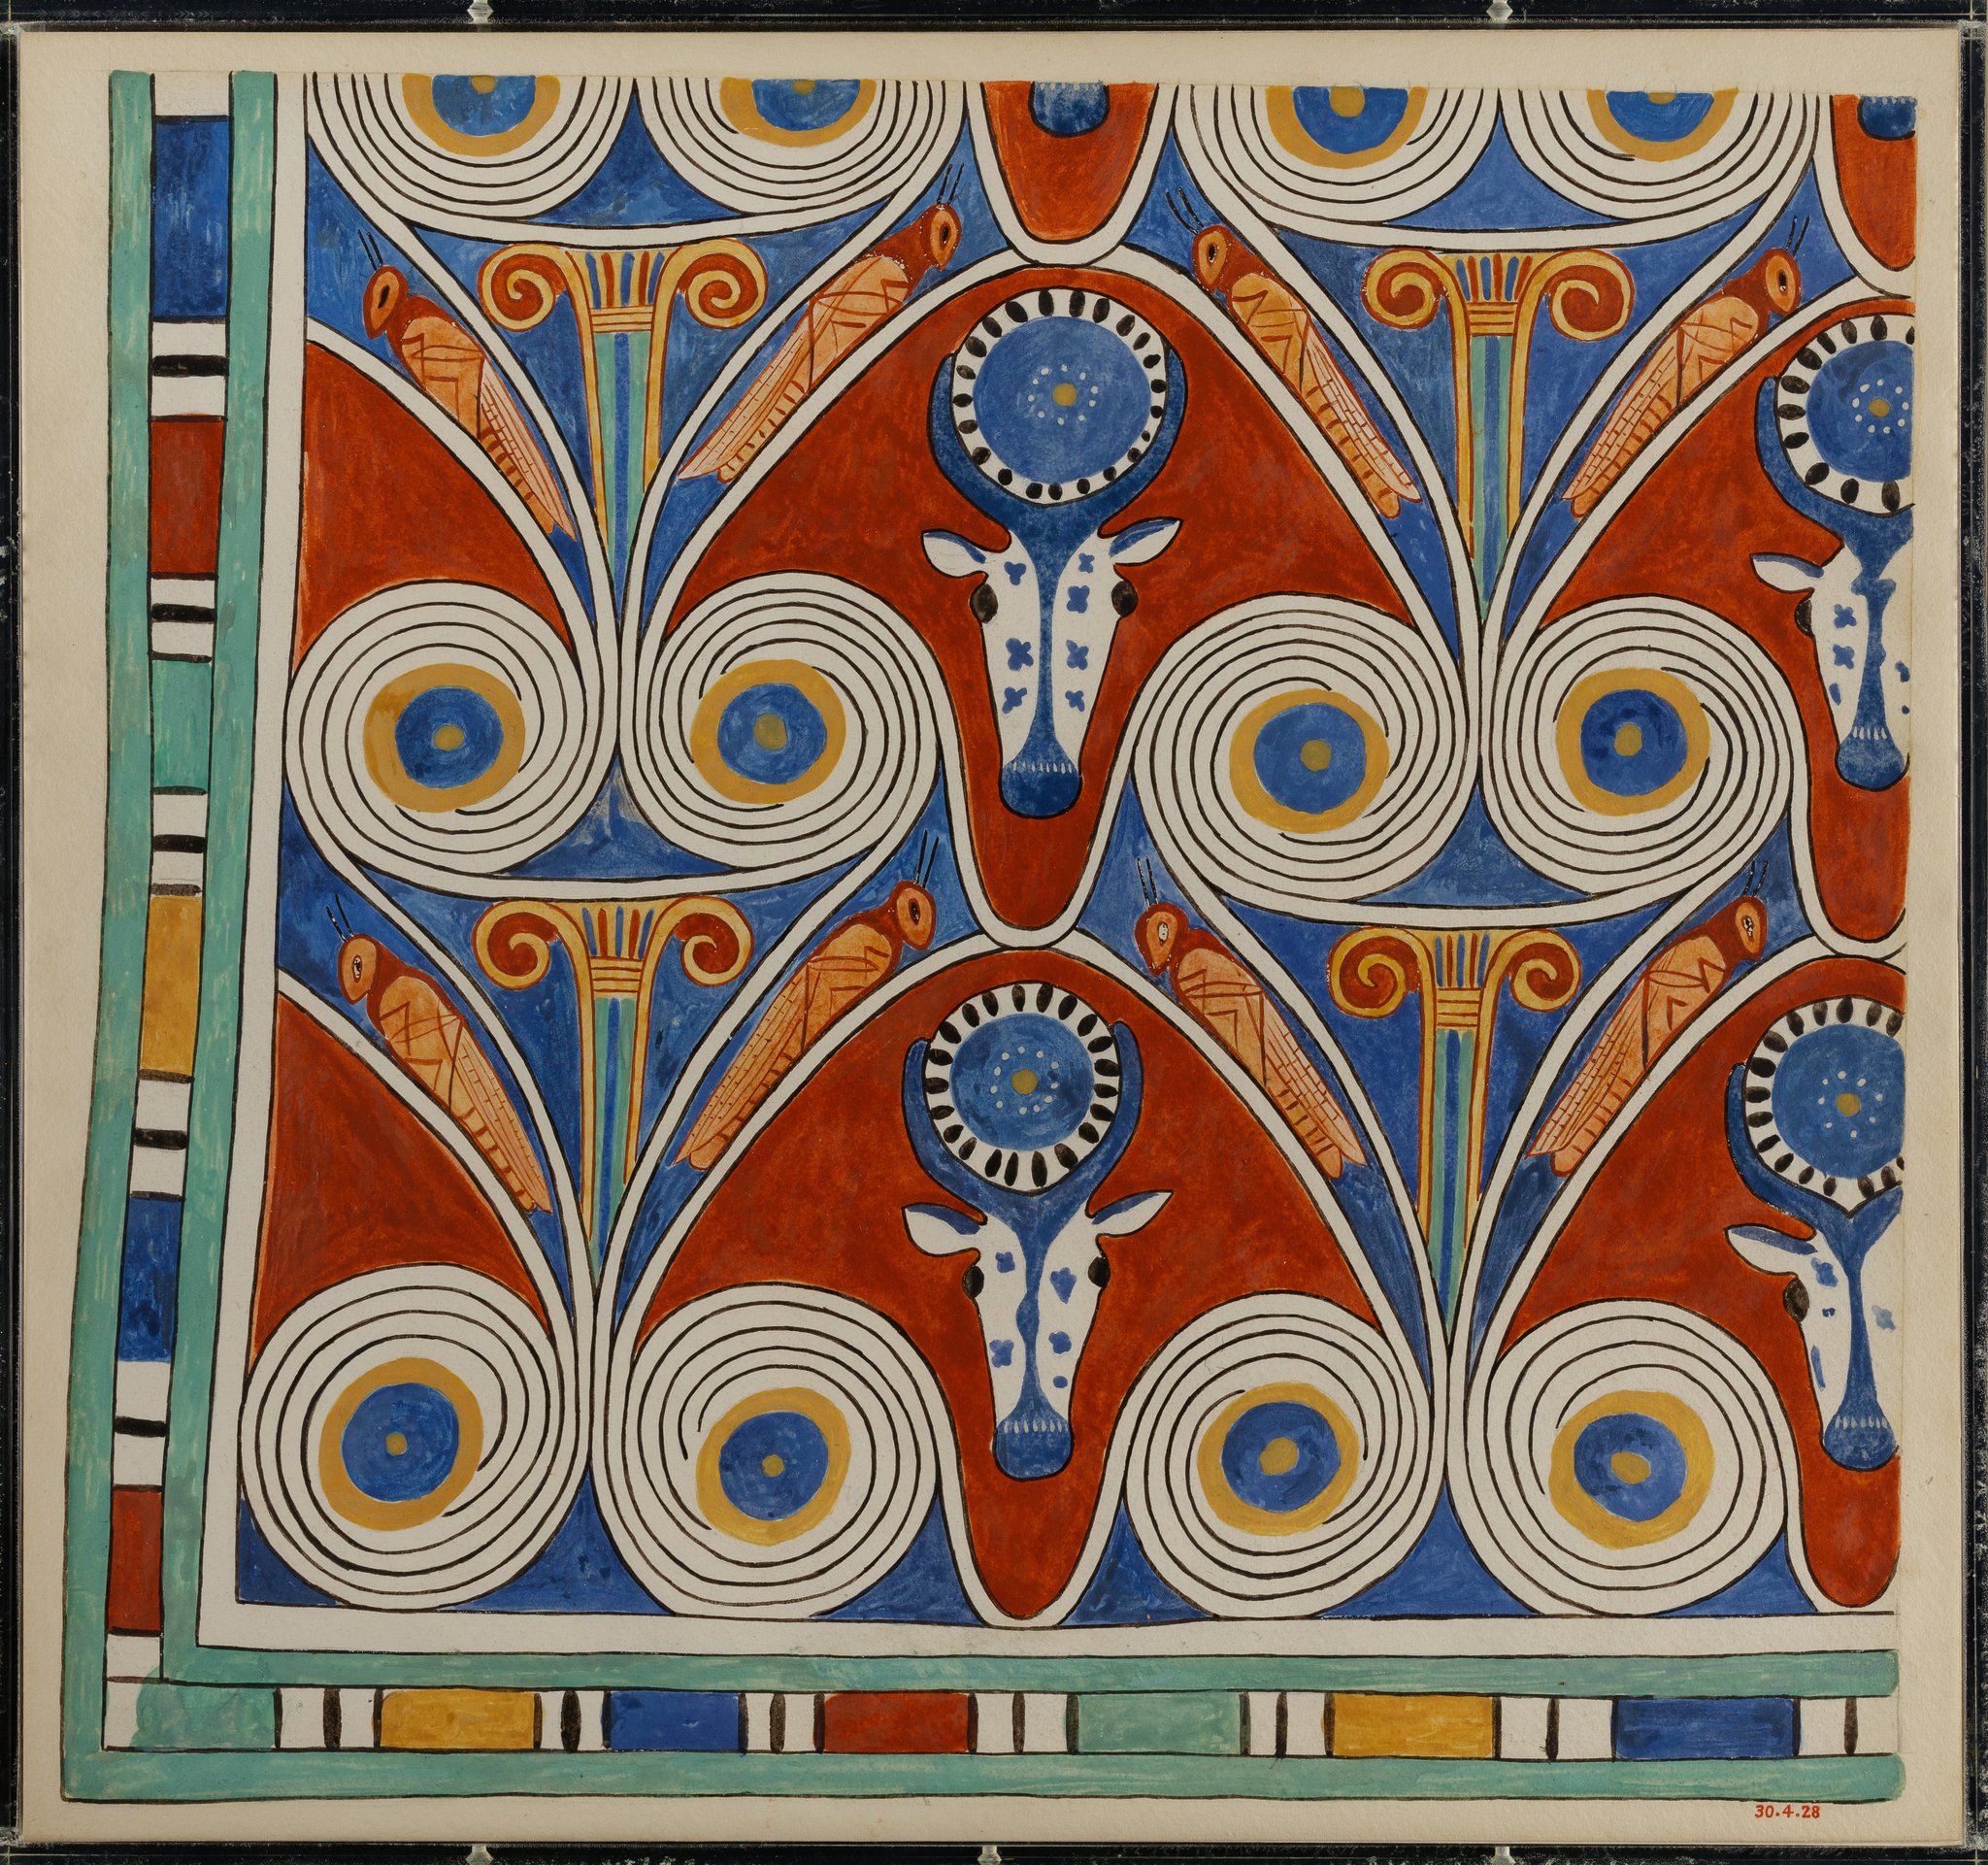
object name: facsimile, neferhotep tt 50, ceiling enhanced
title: Ceiling Fragment, Tomb of Neferhotep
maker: charles k. wilkinson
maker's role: artist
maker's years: 1897-1986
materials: paper, paint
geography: egypt